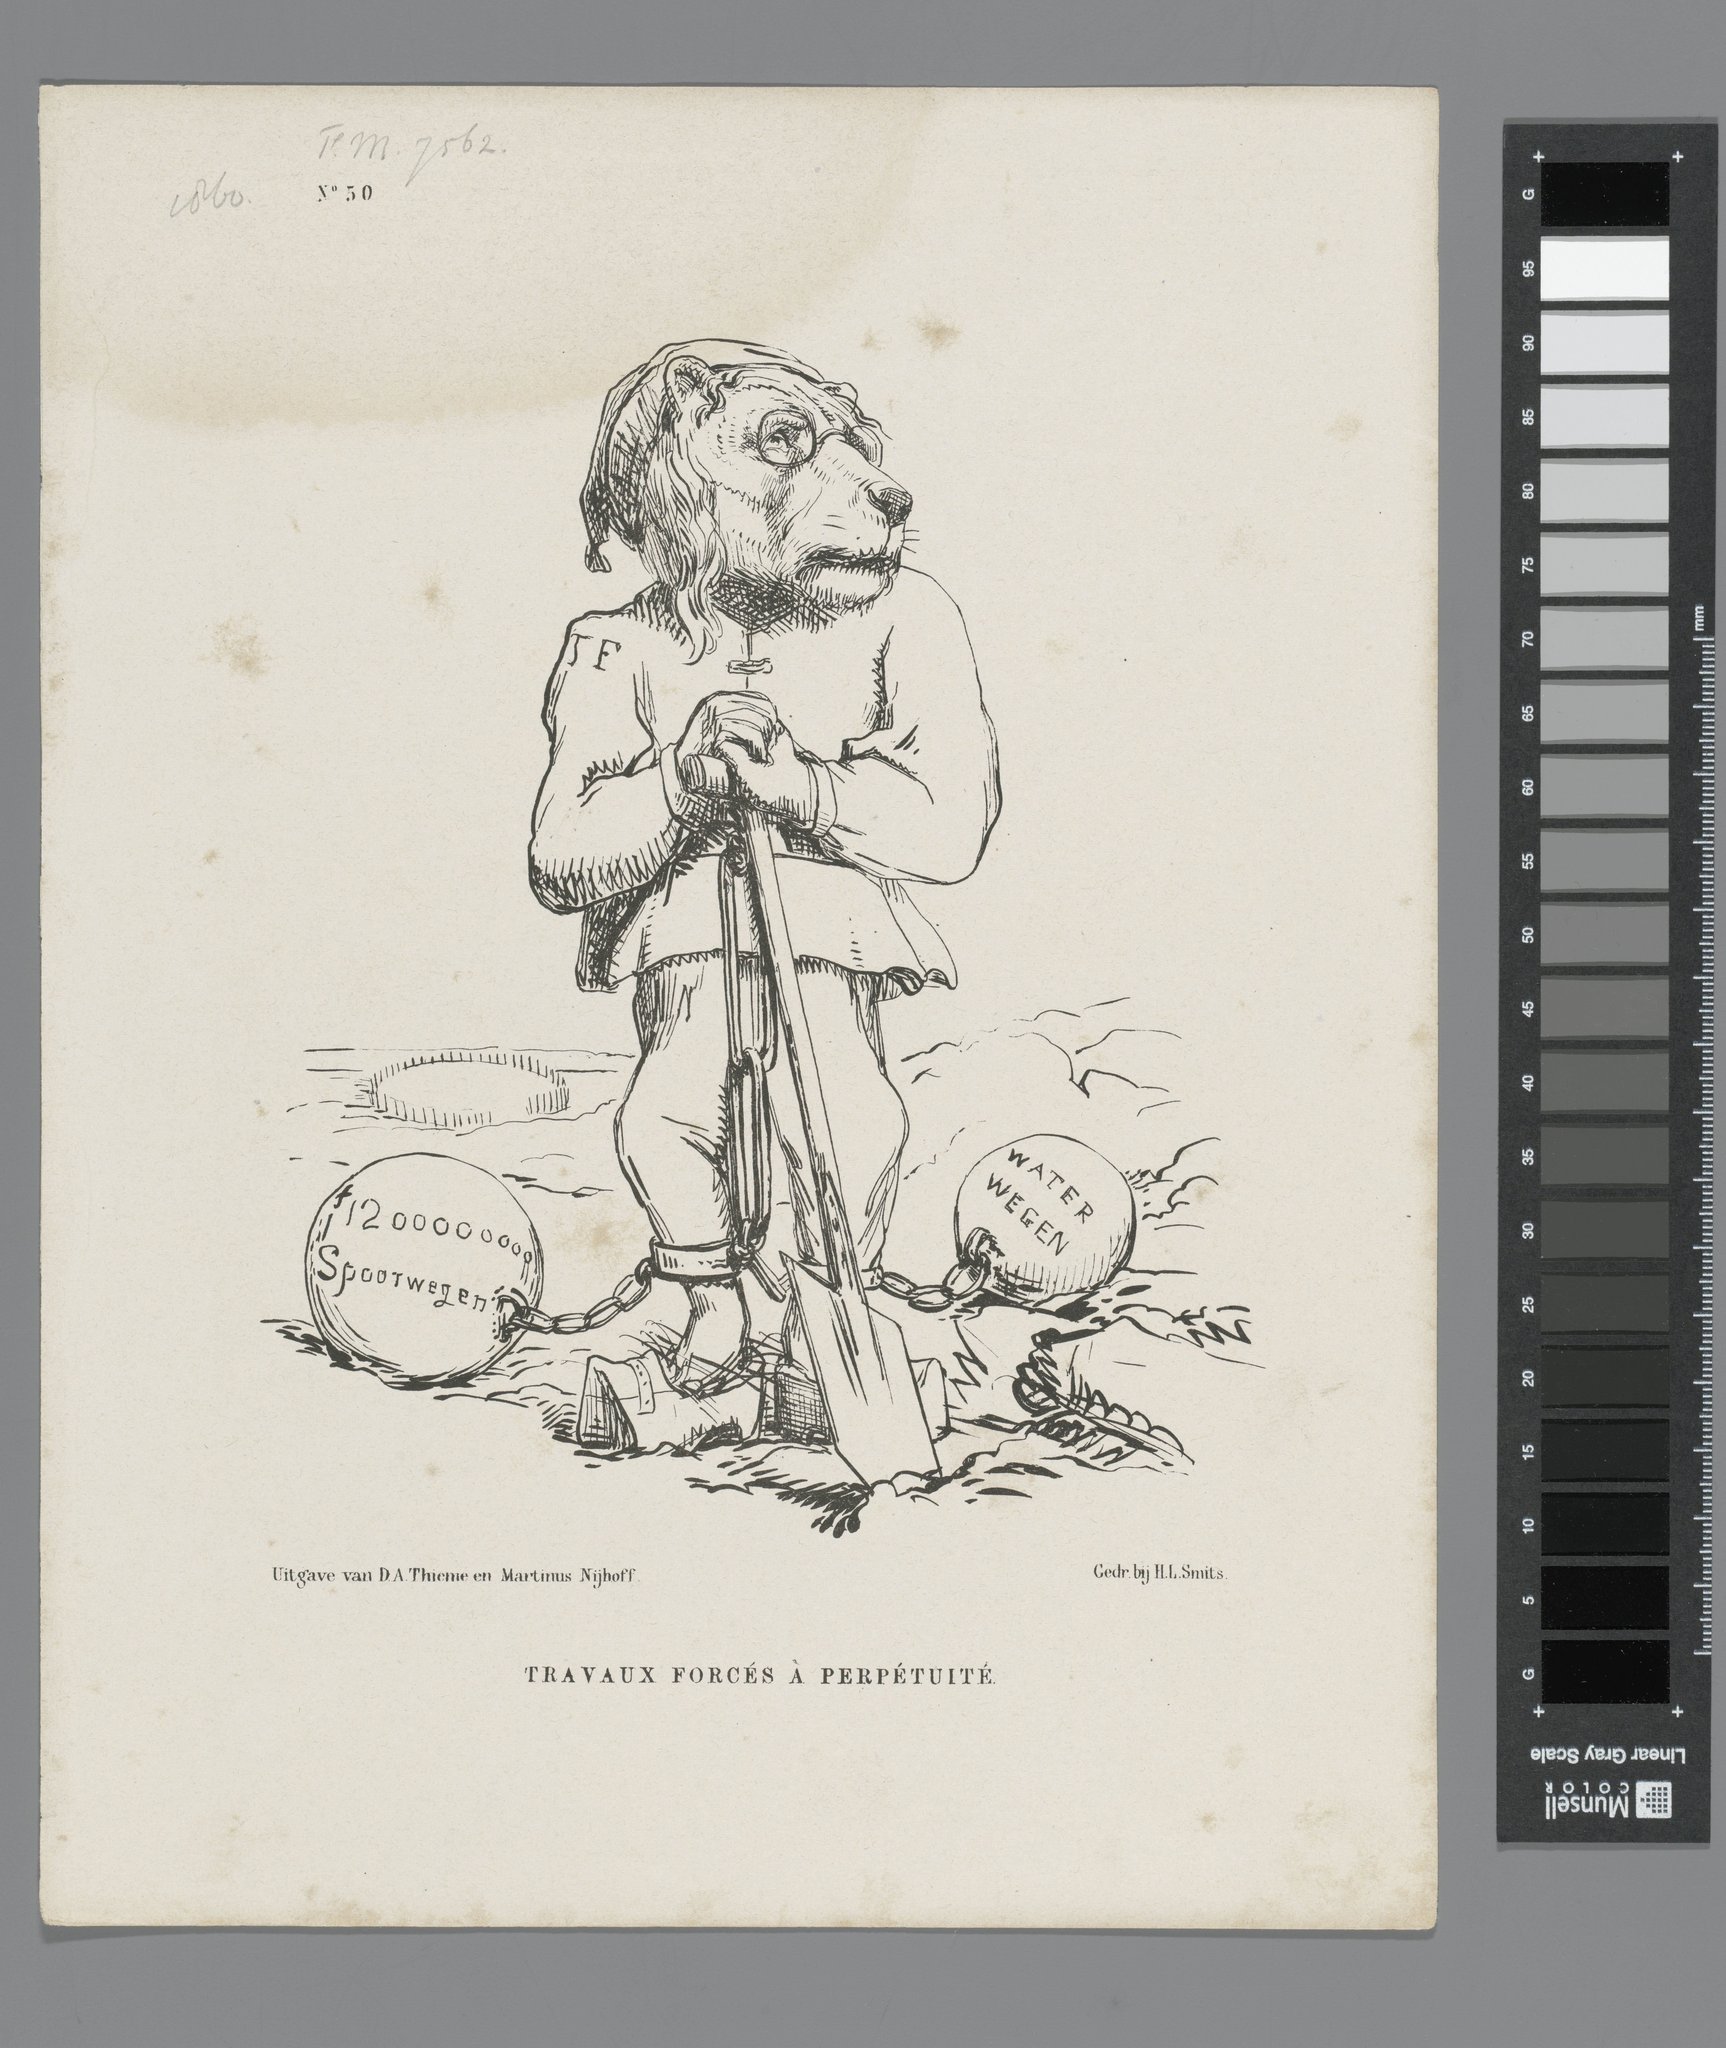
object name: print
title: Travaux forcés à perpétuité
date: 1860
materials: paper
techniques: lithograph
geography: the hague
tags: slavery; serfs and enslaved persons, beasts of prey, predatory animals: lion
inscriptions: collector's mark: Lugt 2228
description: Spotprent op de zware financiële belasting op het land door de grote werken aan de spoorwegen en waterwegen naar Amsterdam en Rotterdam. De Nederlandse Leeuw als een strafgevangene geketend met twee grote kogels aan zijn poten. Plaat verschenen bij het weekblad De Nederlandsche Spectator, nr. 50, 15 december 1860.